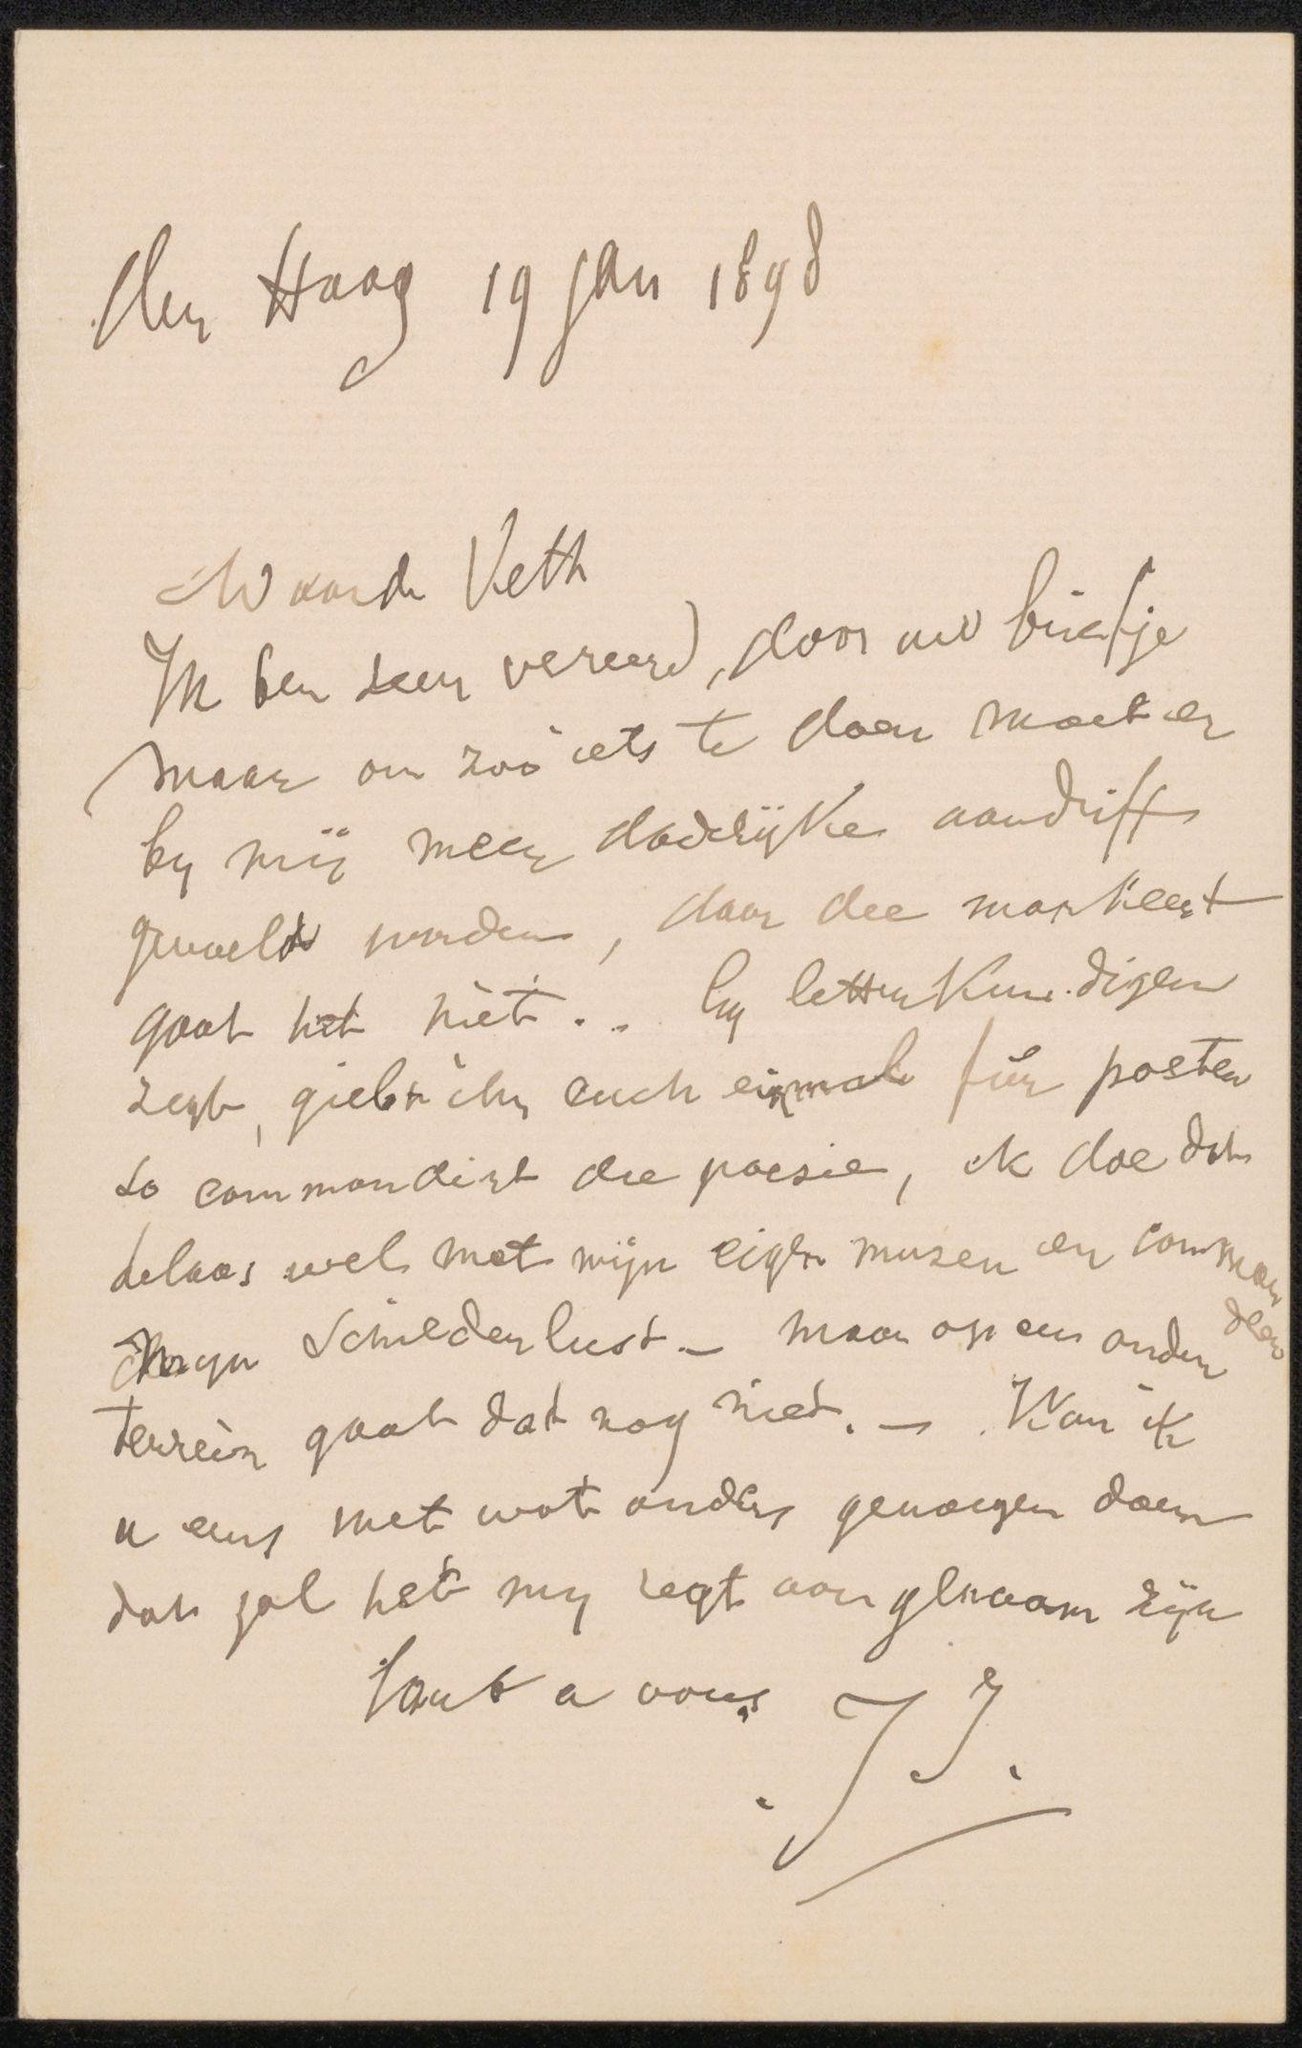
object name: letter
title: Brief aan Jan Veth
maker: jozef israëls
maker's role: draughtsman, painter, print maker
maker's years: 1824-1911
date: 1898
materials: ink, paper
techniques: pen, writing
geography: the hague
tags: dordrecht, painter, print maker, draughtsman, designer, jan veth, painting (including book-illumination, miniature-painting)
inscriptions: collector's mark: ‘RPK’